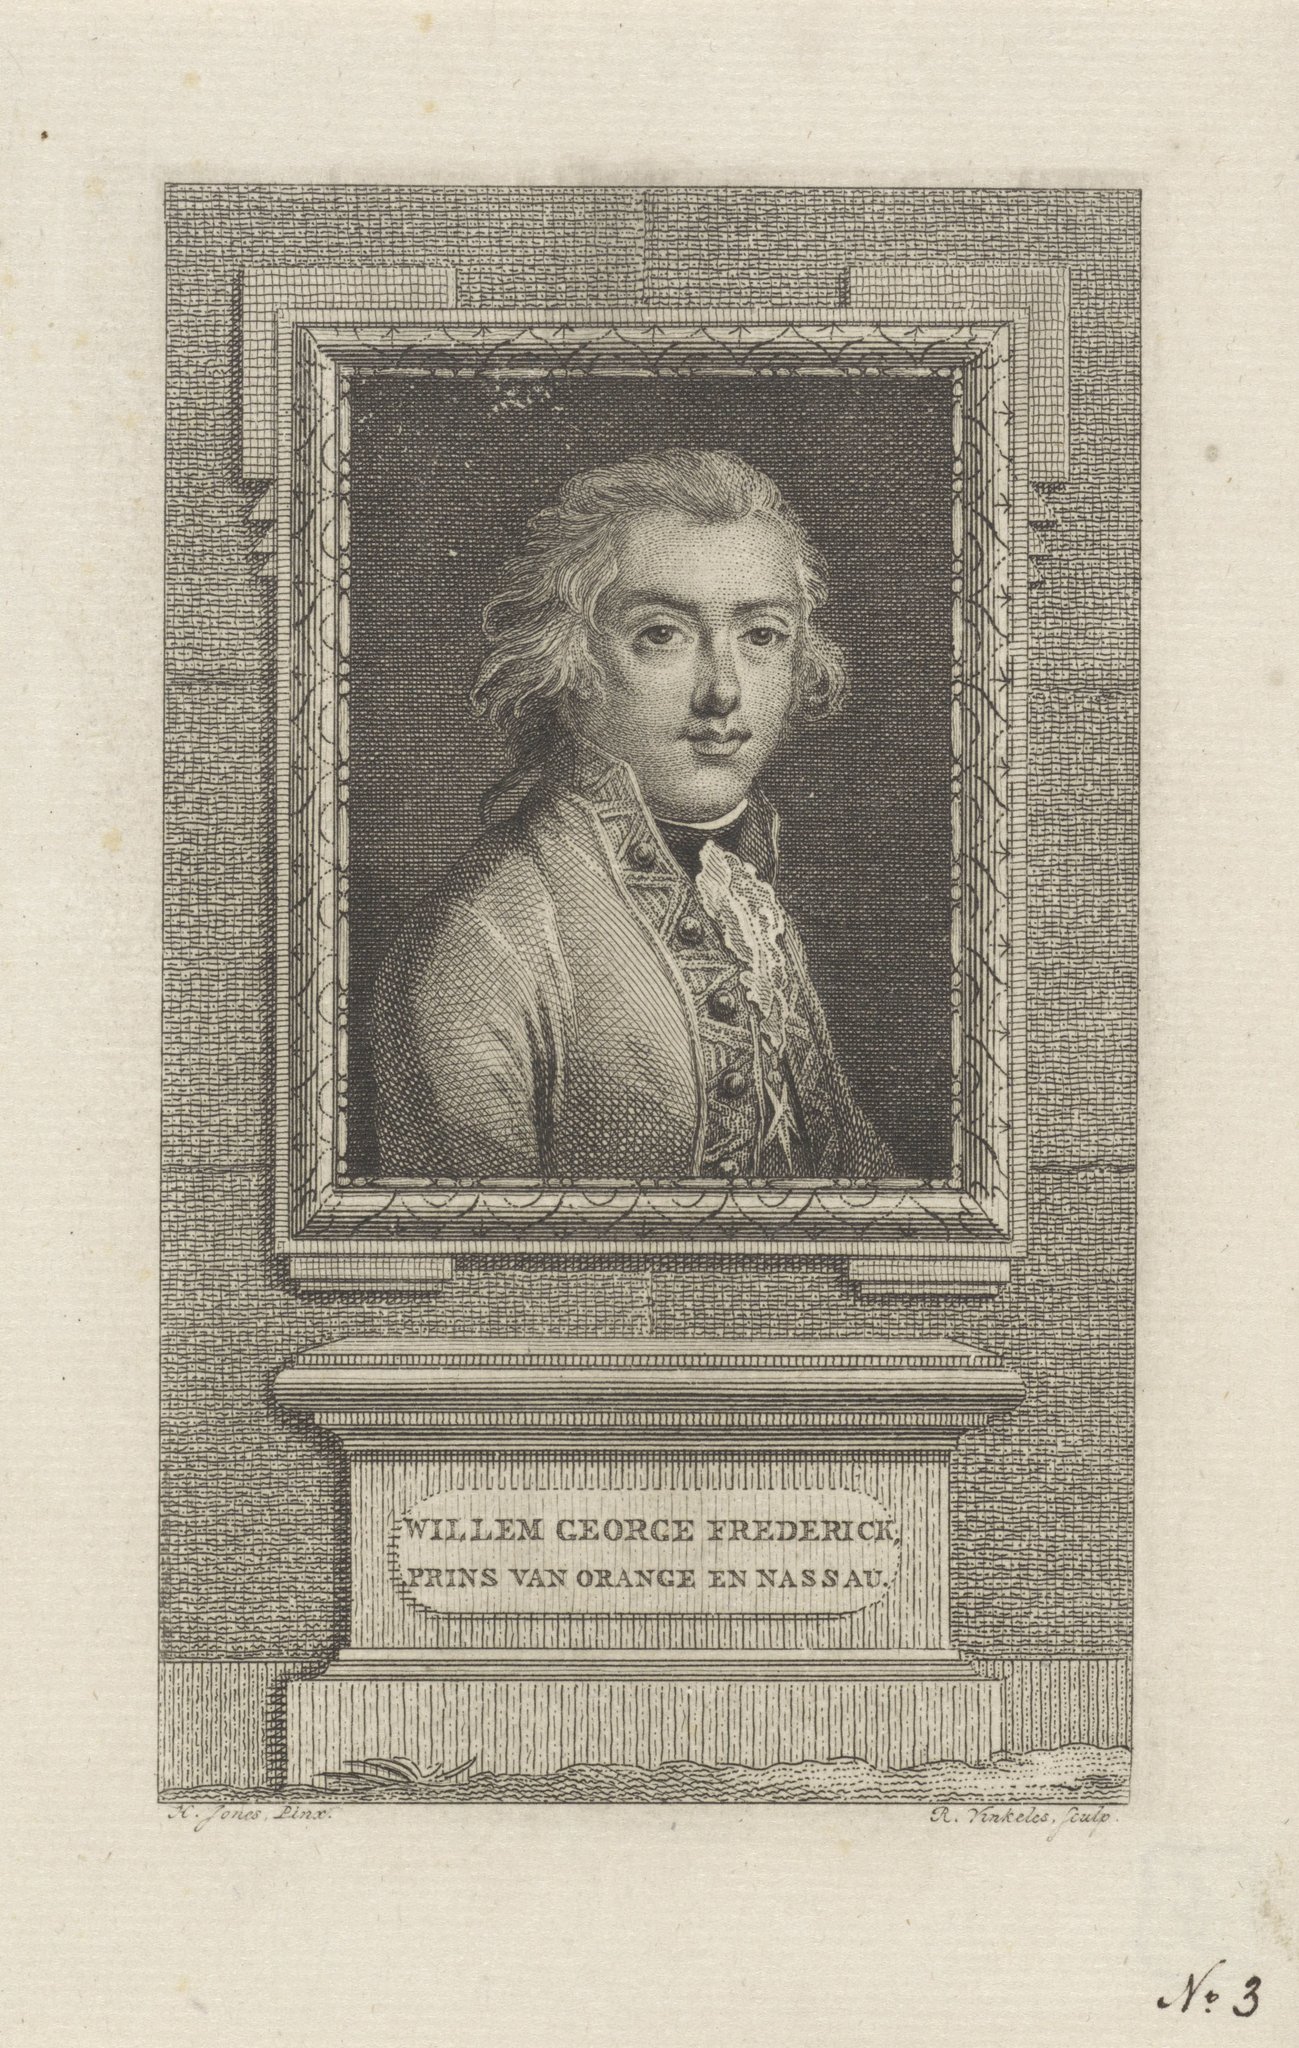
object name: print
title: Portret van Willem George Frederik, prins van Oranje-Nassau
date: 1786-1809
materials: paper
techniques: etching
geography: amsterdam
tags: the hague, willem george frederik (prins van oranje-nassau)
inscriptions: collector's mark: Lugt 2228, collector's mark: Lugt 963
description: Prent ook gebruikt als boekillustratie in: Wagenaar, Jan. Vaderlandsche historie, (...) ten vervolge van Wagenaars Vaderlandsche historie. Dl. 1-43. Amsterdam: Johannes Allart, 1786-1809.